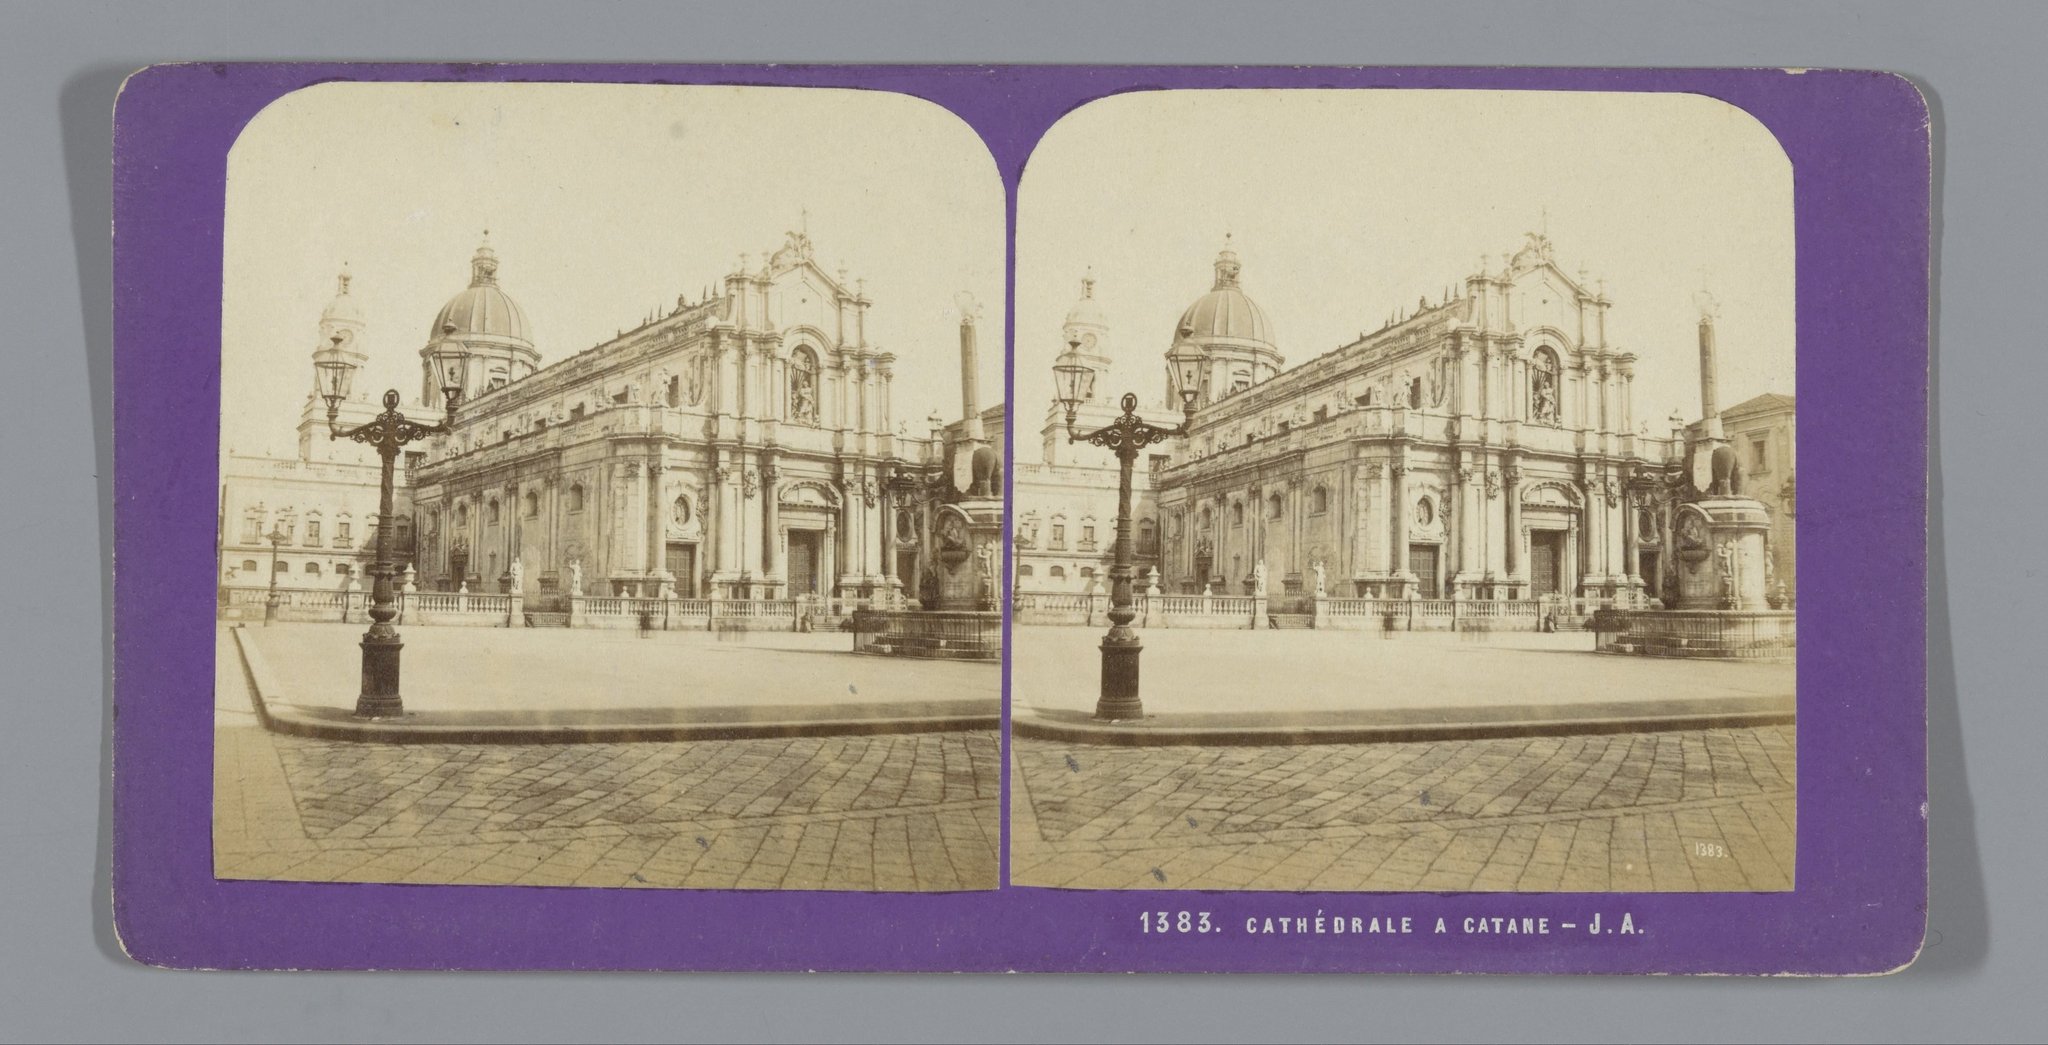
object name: stereograph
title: Gezicht op de kathedraal van Catania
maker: jean andrieu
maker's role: fotograaf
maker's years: 1816-1872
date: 1862-1876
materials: cardboard, paper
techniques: albumen print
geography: catania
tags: abbey, monastery, convent ~ roman catholic church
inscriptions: number: ‘1383’